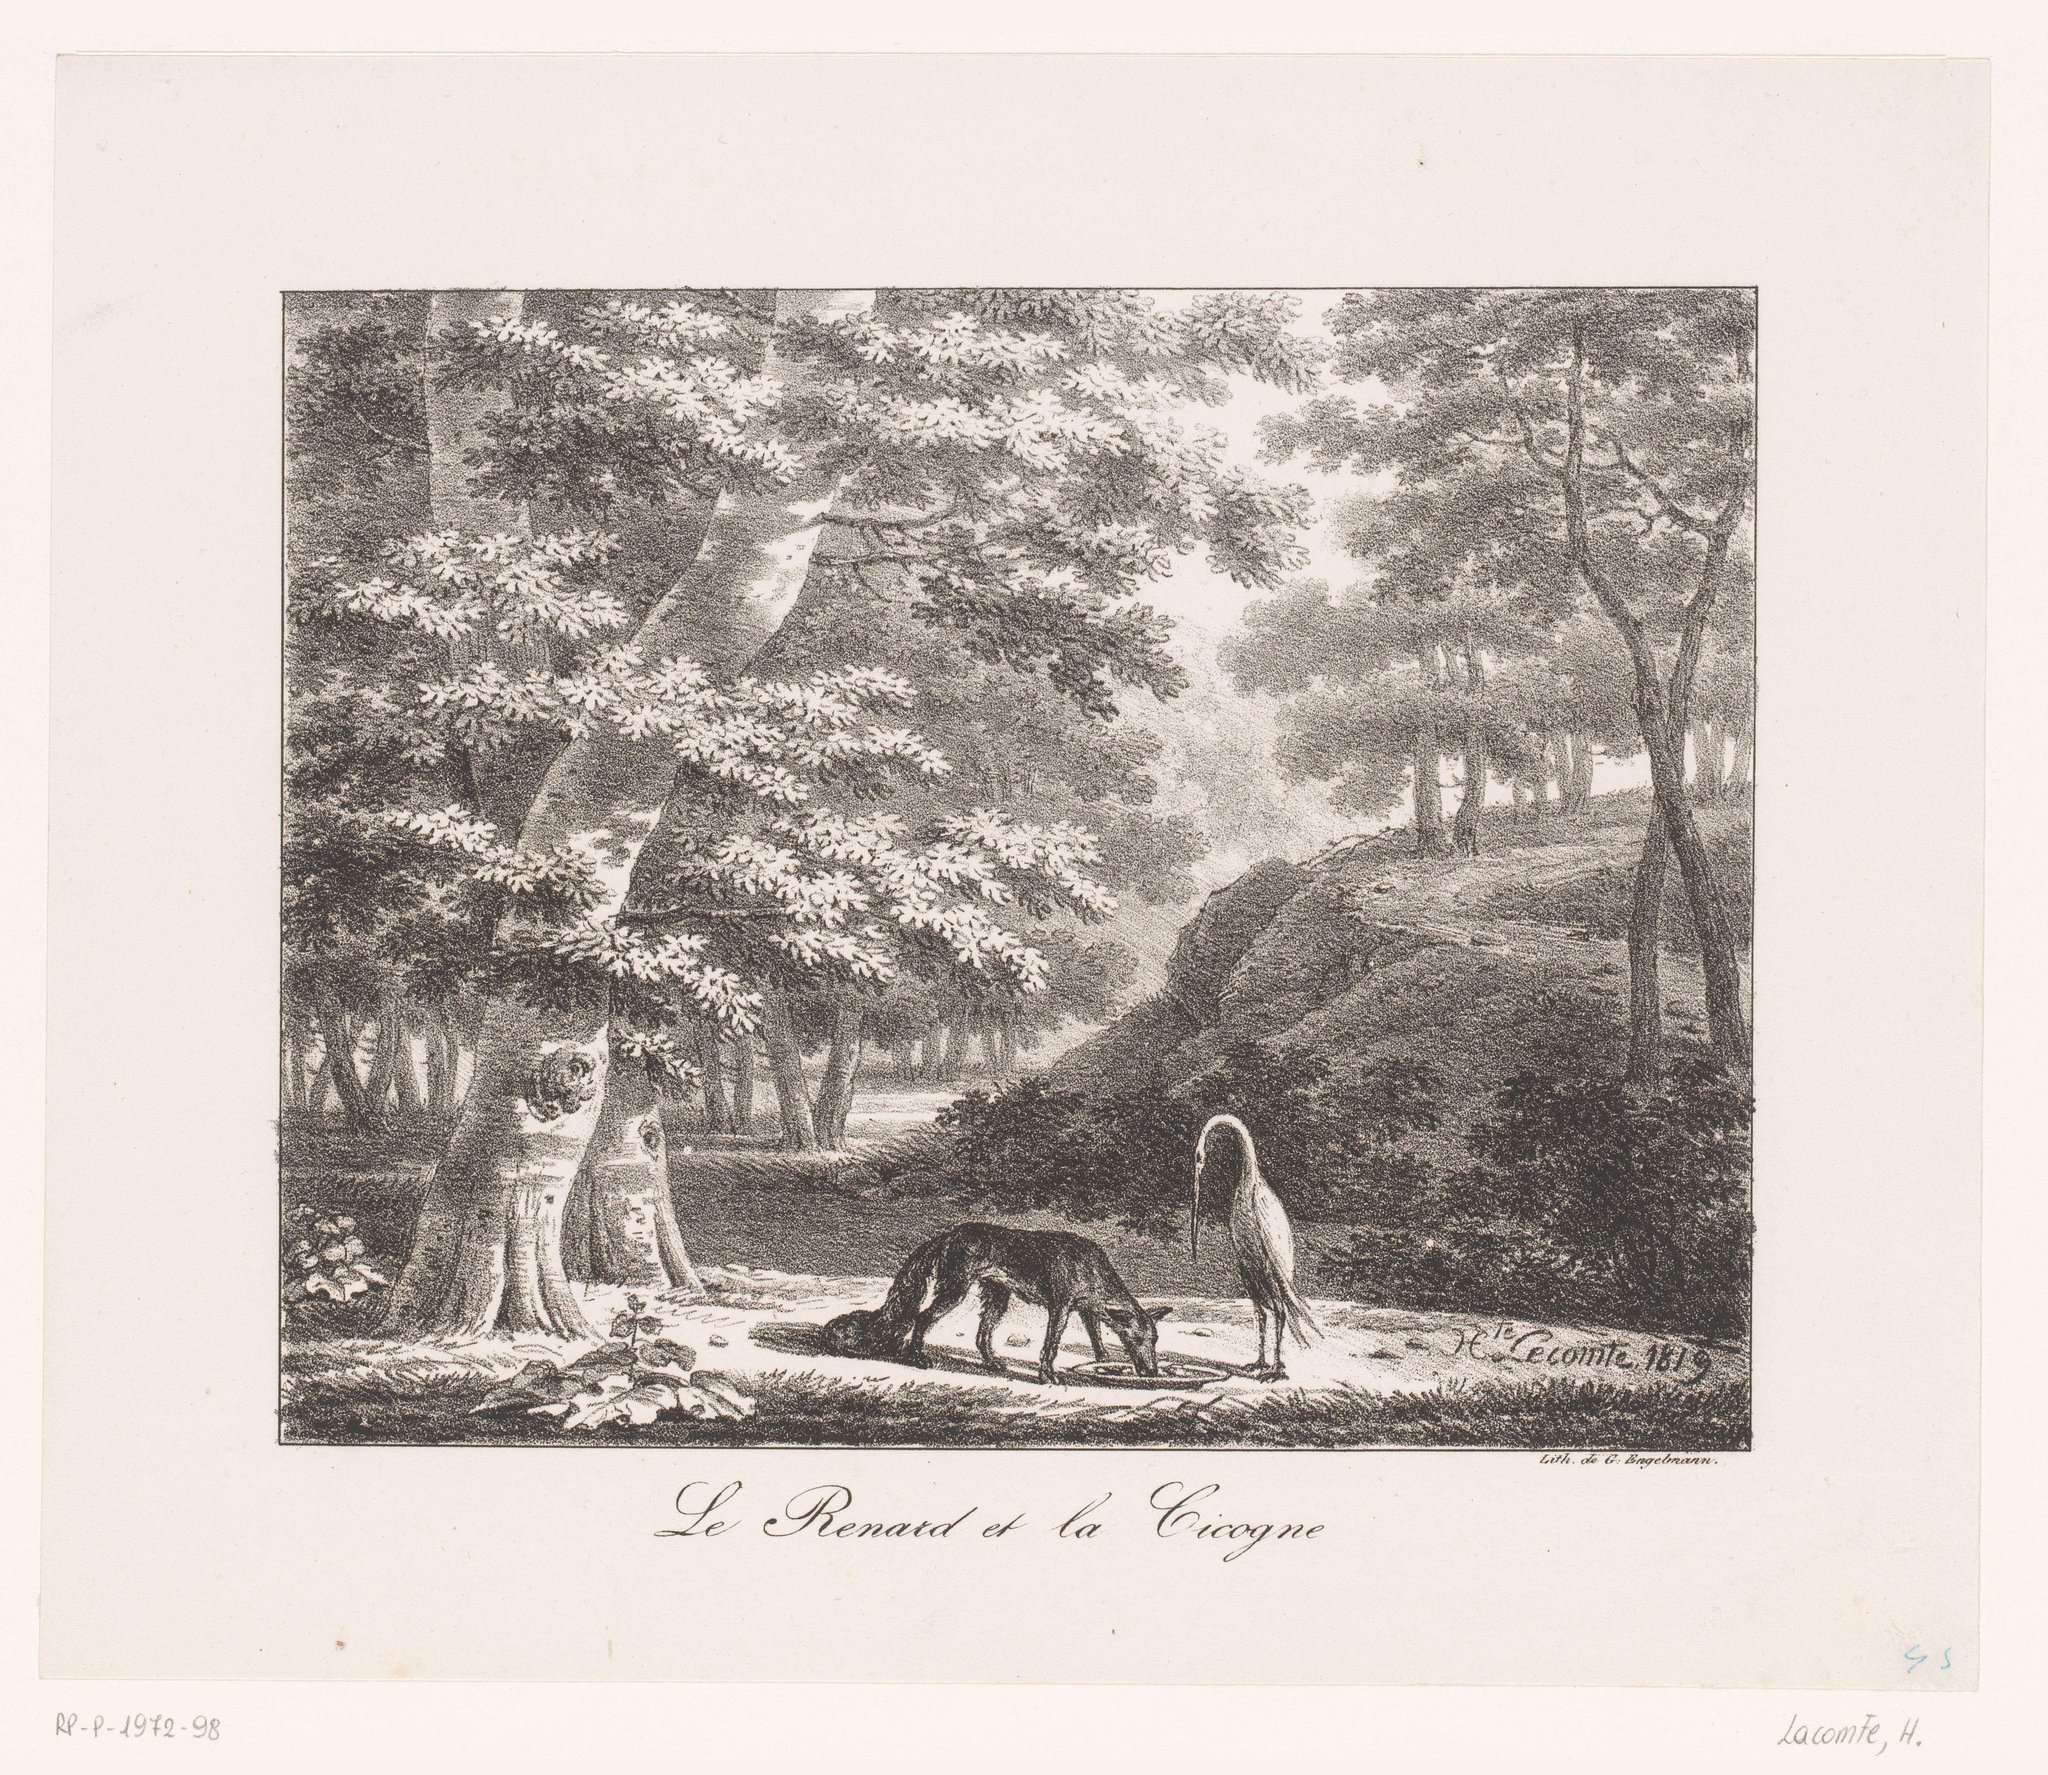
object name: print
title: Vos en ooievaar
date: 1819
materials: paper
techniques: lithograph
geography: paris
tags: shore-birds and wading-birds: stork, fables of lafontaine (with title) : use 85(...), beasts of prey, predatory animals: fox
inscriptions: collector's mark: Lugt 2760, collector's mark: Lugt 2228a